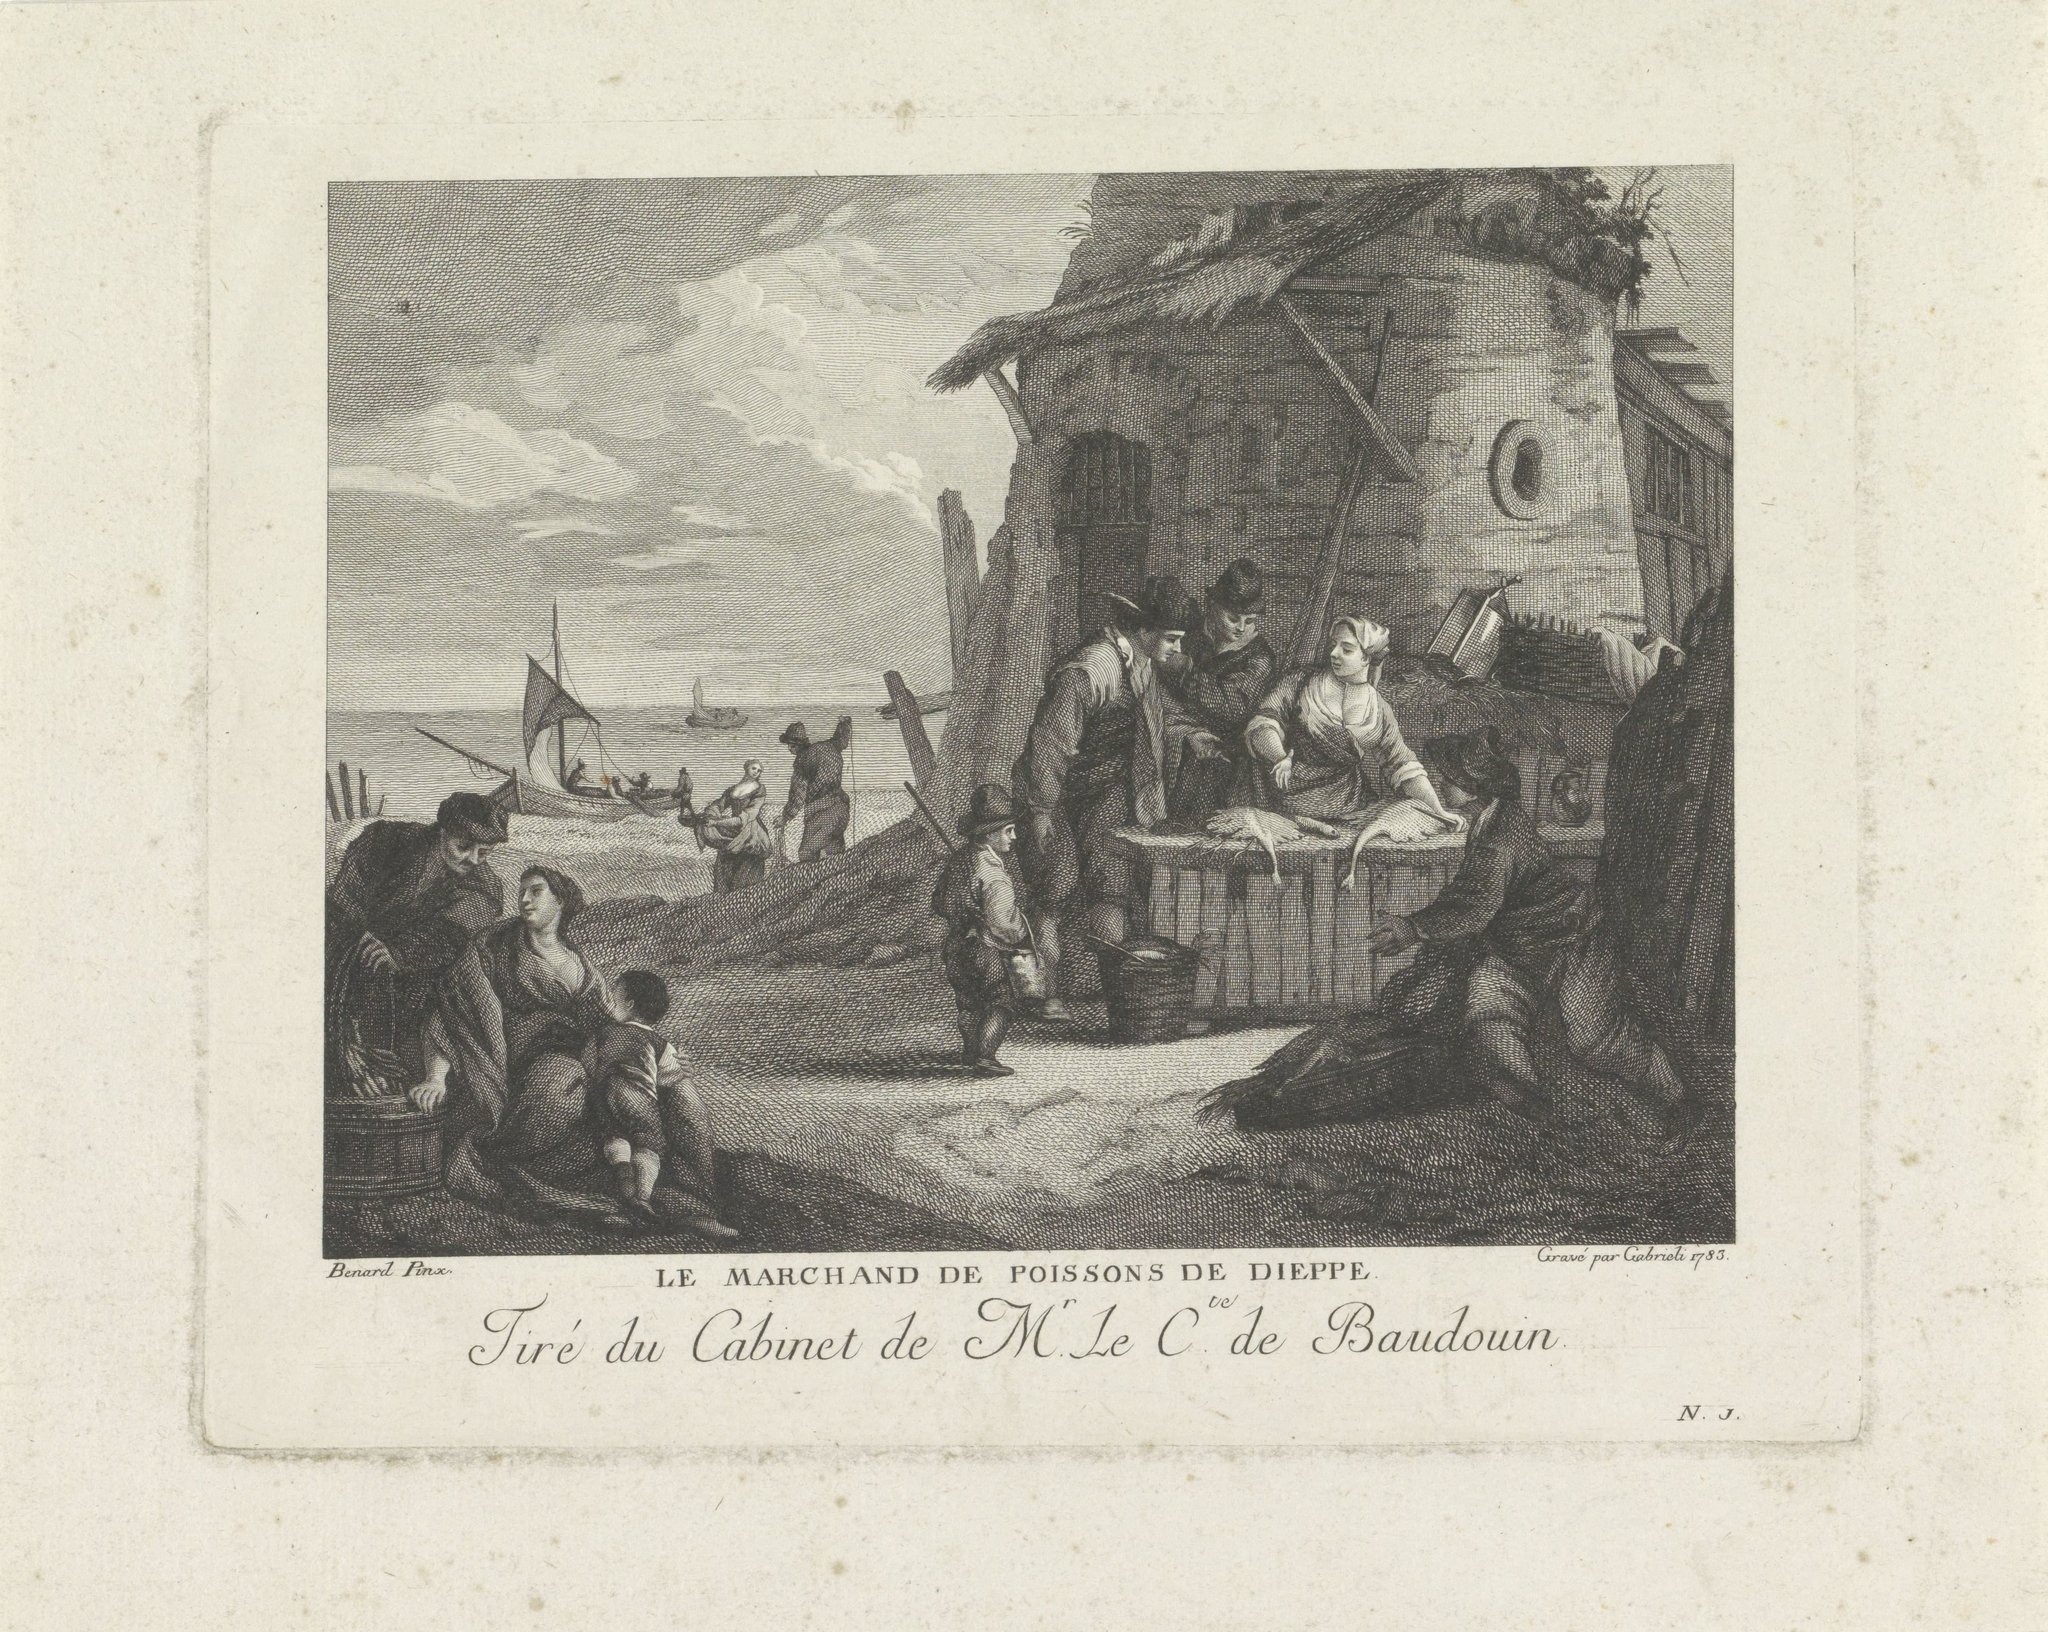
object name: print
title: De visverkoopster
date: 1783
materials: paper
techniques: engraving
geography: italy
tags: fisherman, merchant, salesman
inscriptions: collector's mark: Lugt 2228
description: Kustlandschap met vissers. Rechts een visverkoopster. Genummerd rechtsonder: N. 1.